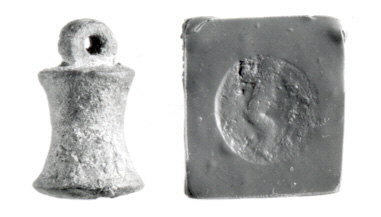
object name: stamp seal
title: Stamp seal (bell-shaped with loop handle) with monster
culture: urartian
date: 800-601 BCE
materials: alloy, bronze, copper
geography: urartu